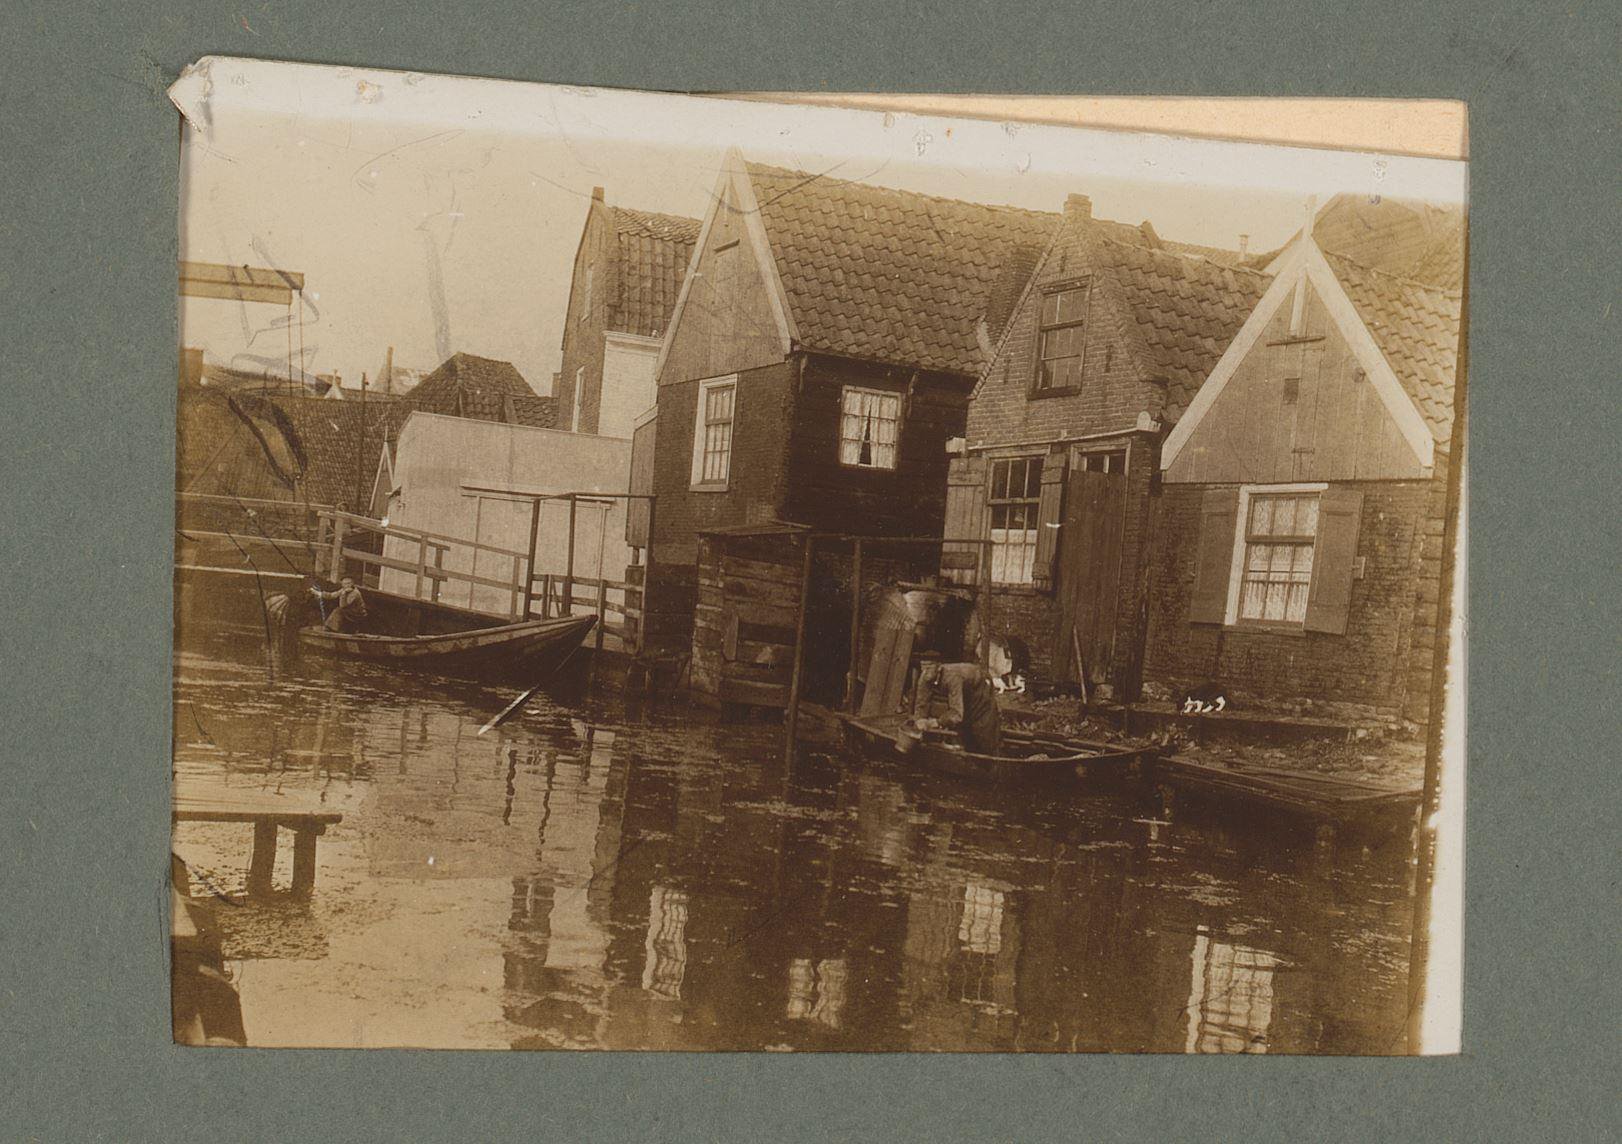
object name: album leaf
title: Aangemeerde roeiboten bij Volendammer huizen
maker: george hidderley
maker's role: fotograaf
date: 1920-1940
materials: photographic support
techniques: gelatin silver print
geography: volendam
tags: canals, waters (in village), rowing-boat, canoe, etc.